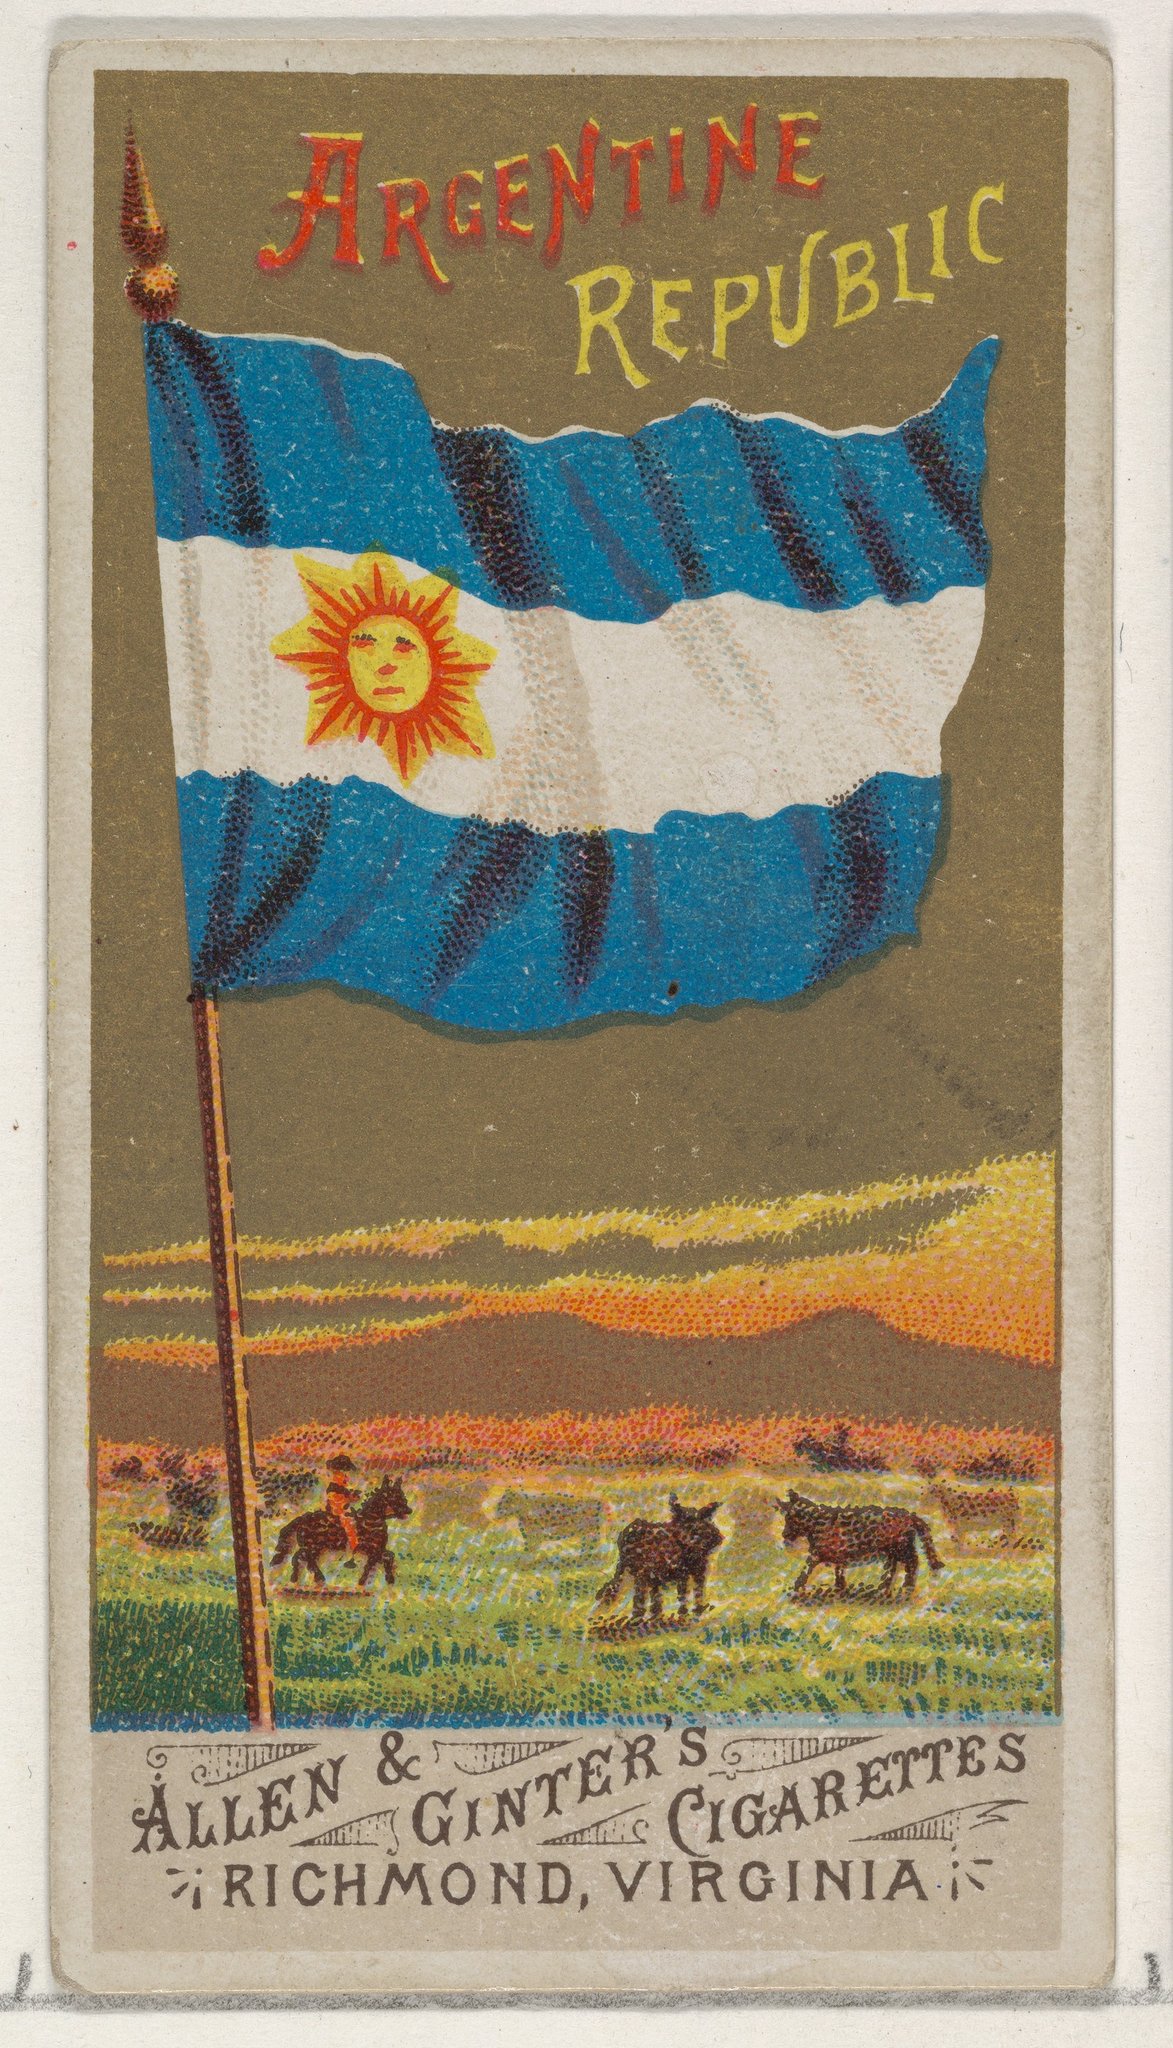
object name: print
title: Argentine Republic, from Flags of All Nations, Series 1 (N9) for Allen & Ginter Cigarettes Brands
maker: allen & ginter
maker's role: publisher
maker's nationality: american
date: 1887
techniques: color lithograph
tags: flags